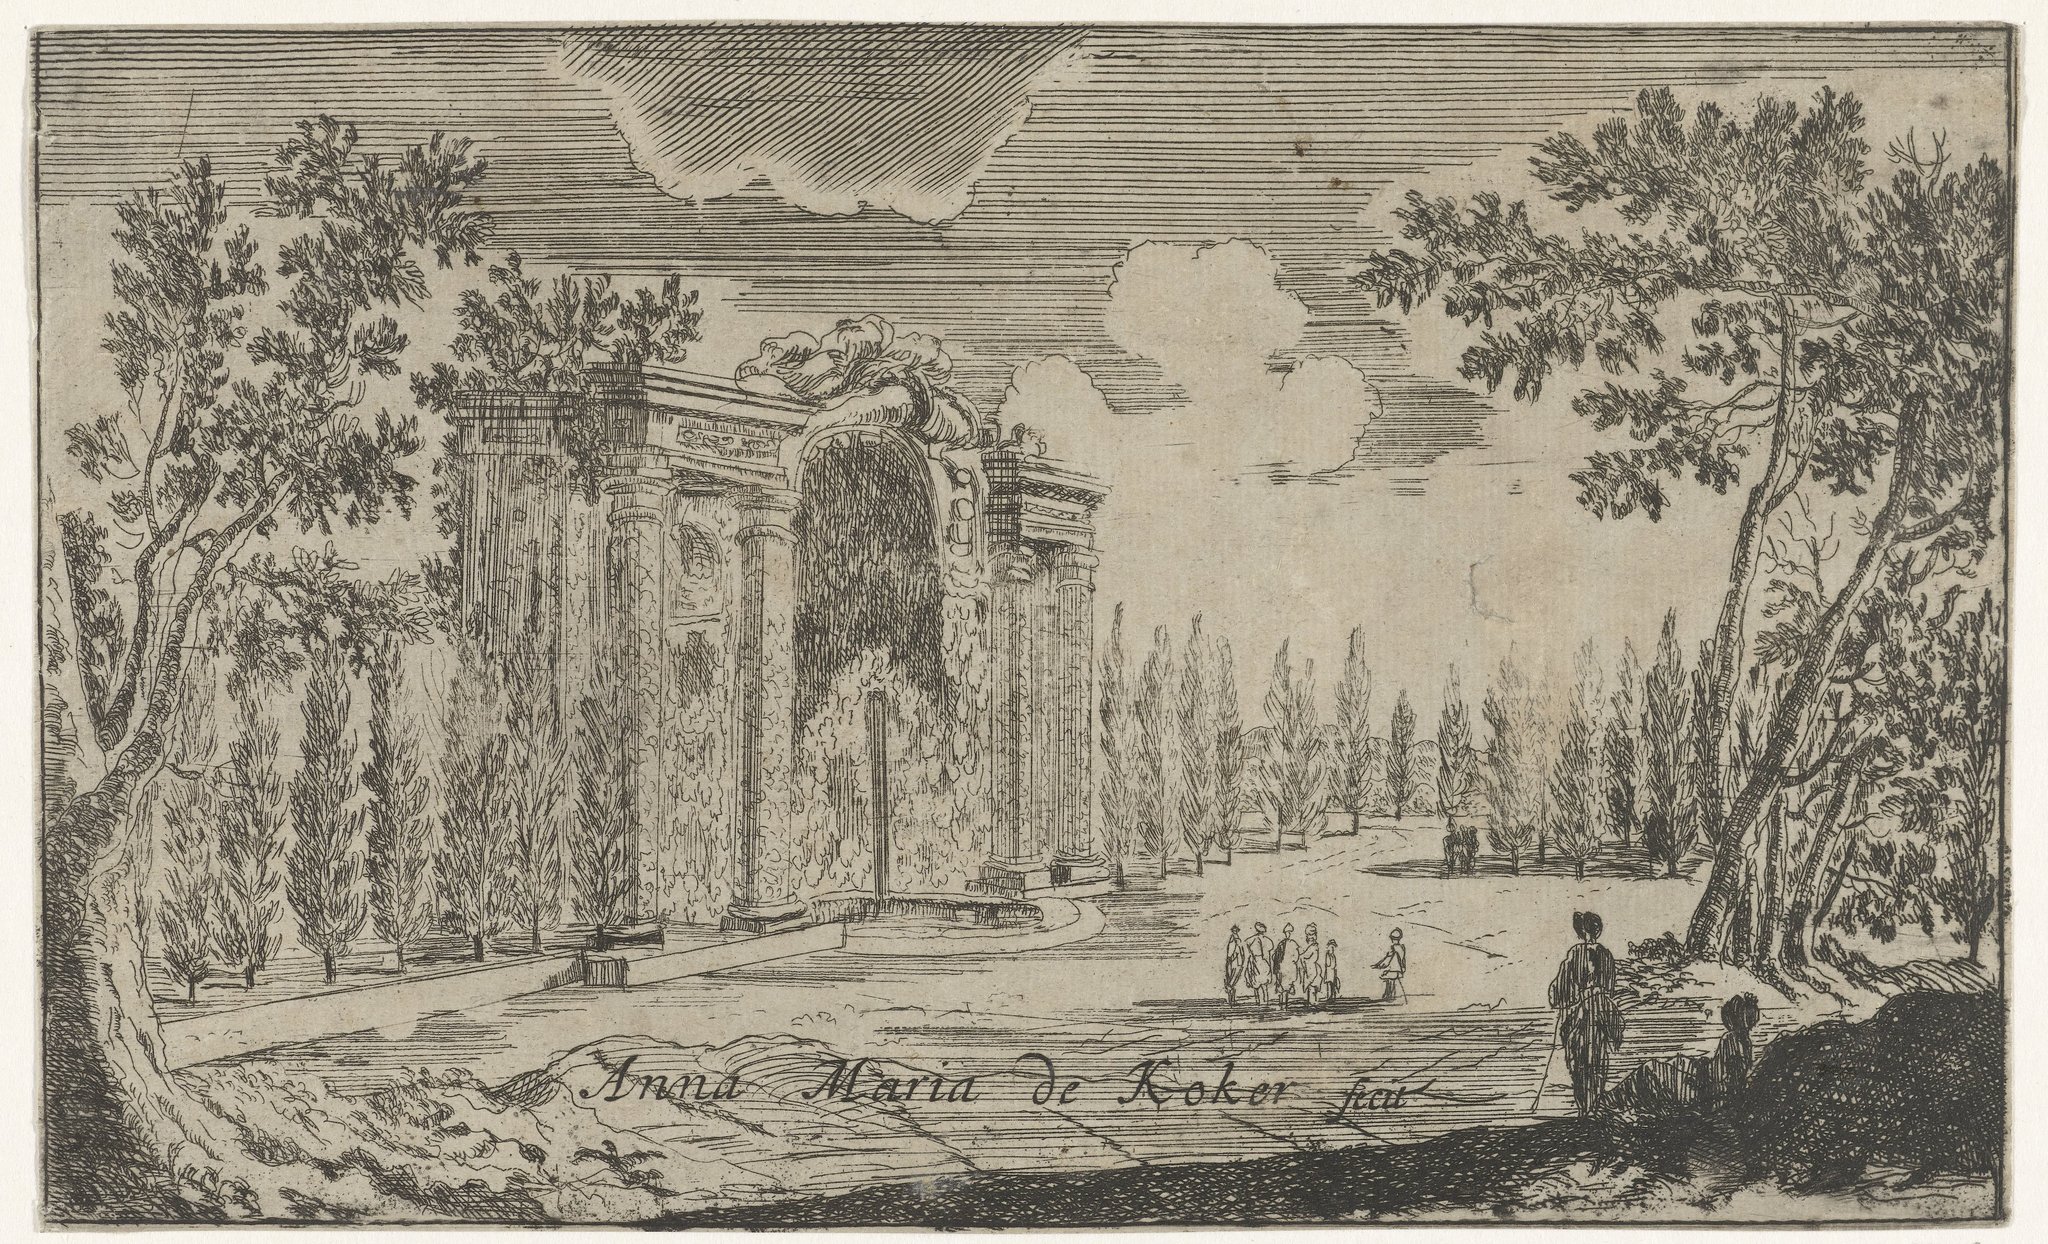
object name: print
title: Parkgezicht met fontein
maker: anna maria de koker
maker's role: print maker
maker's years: -1698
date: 1640-1698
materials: paper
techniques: etching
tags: garden ornaments, public gardens, park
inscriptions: collector's mark: Lugt 2228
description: Parkgezicht met een grote fontein, met een gedecoreerde boog en zuilen. Voor de fontein staat een gezelschap van zes personen deze te bewonderen. Rechts op de voorgrond een man met een stok in de hand, naast hem een zittende vrouw.